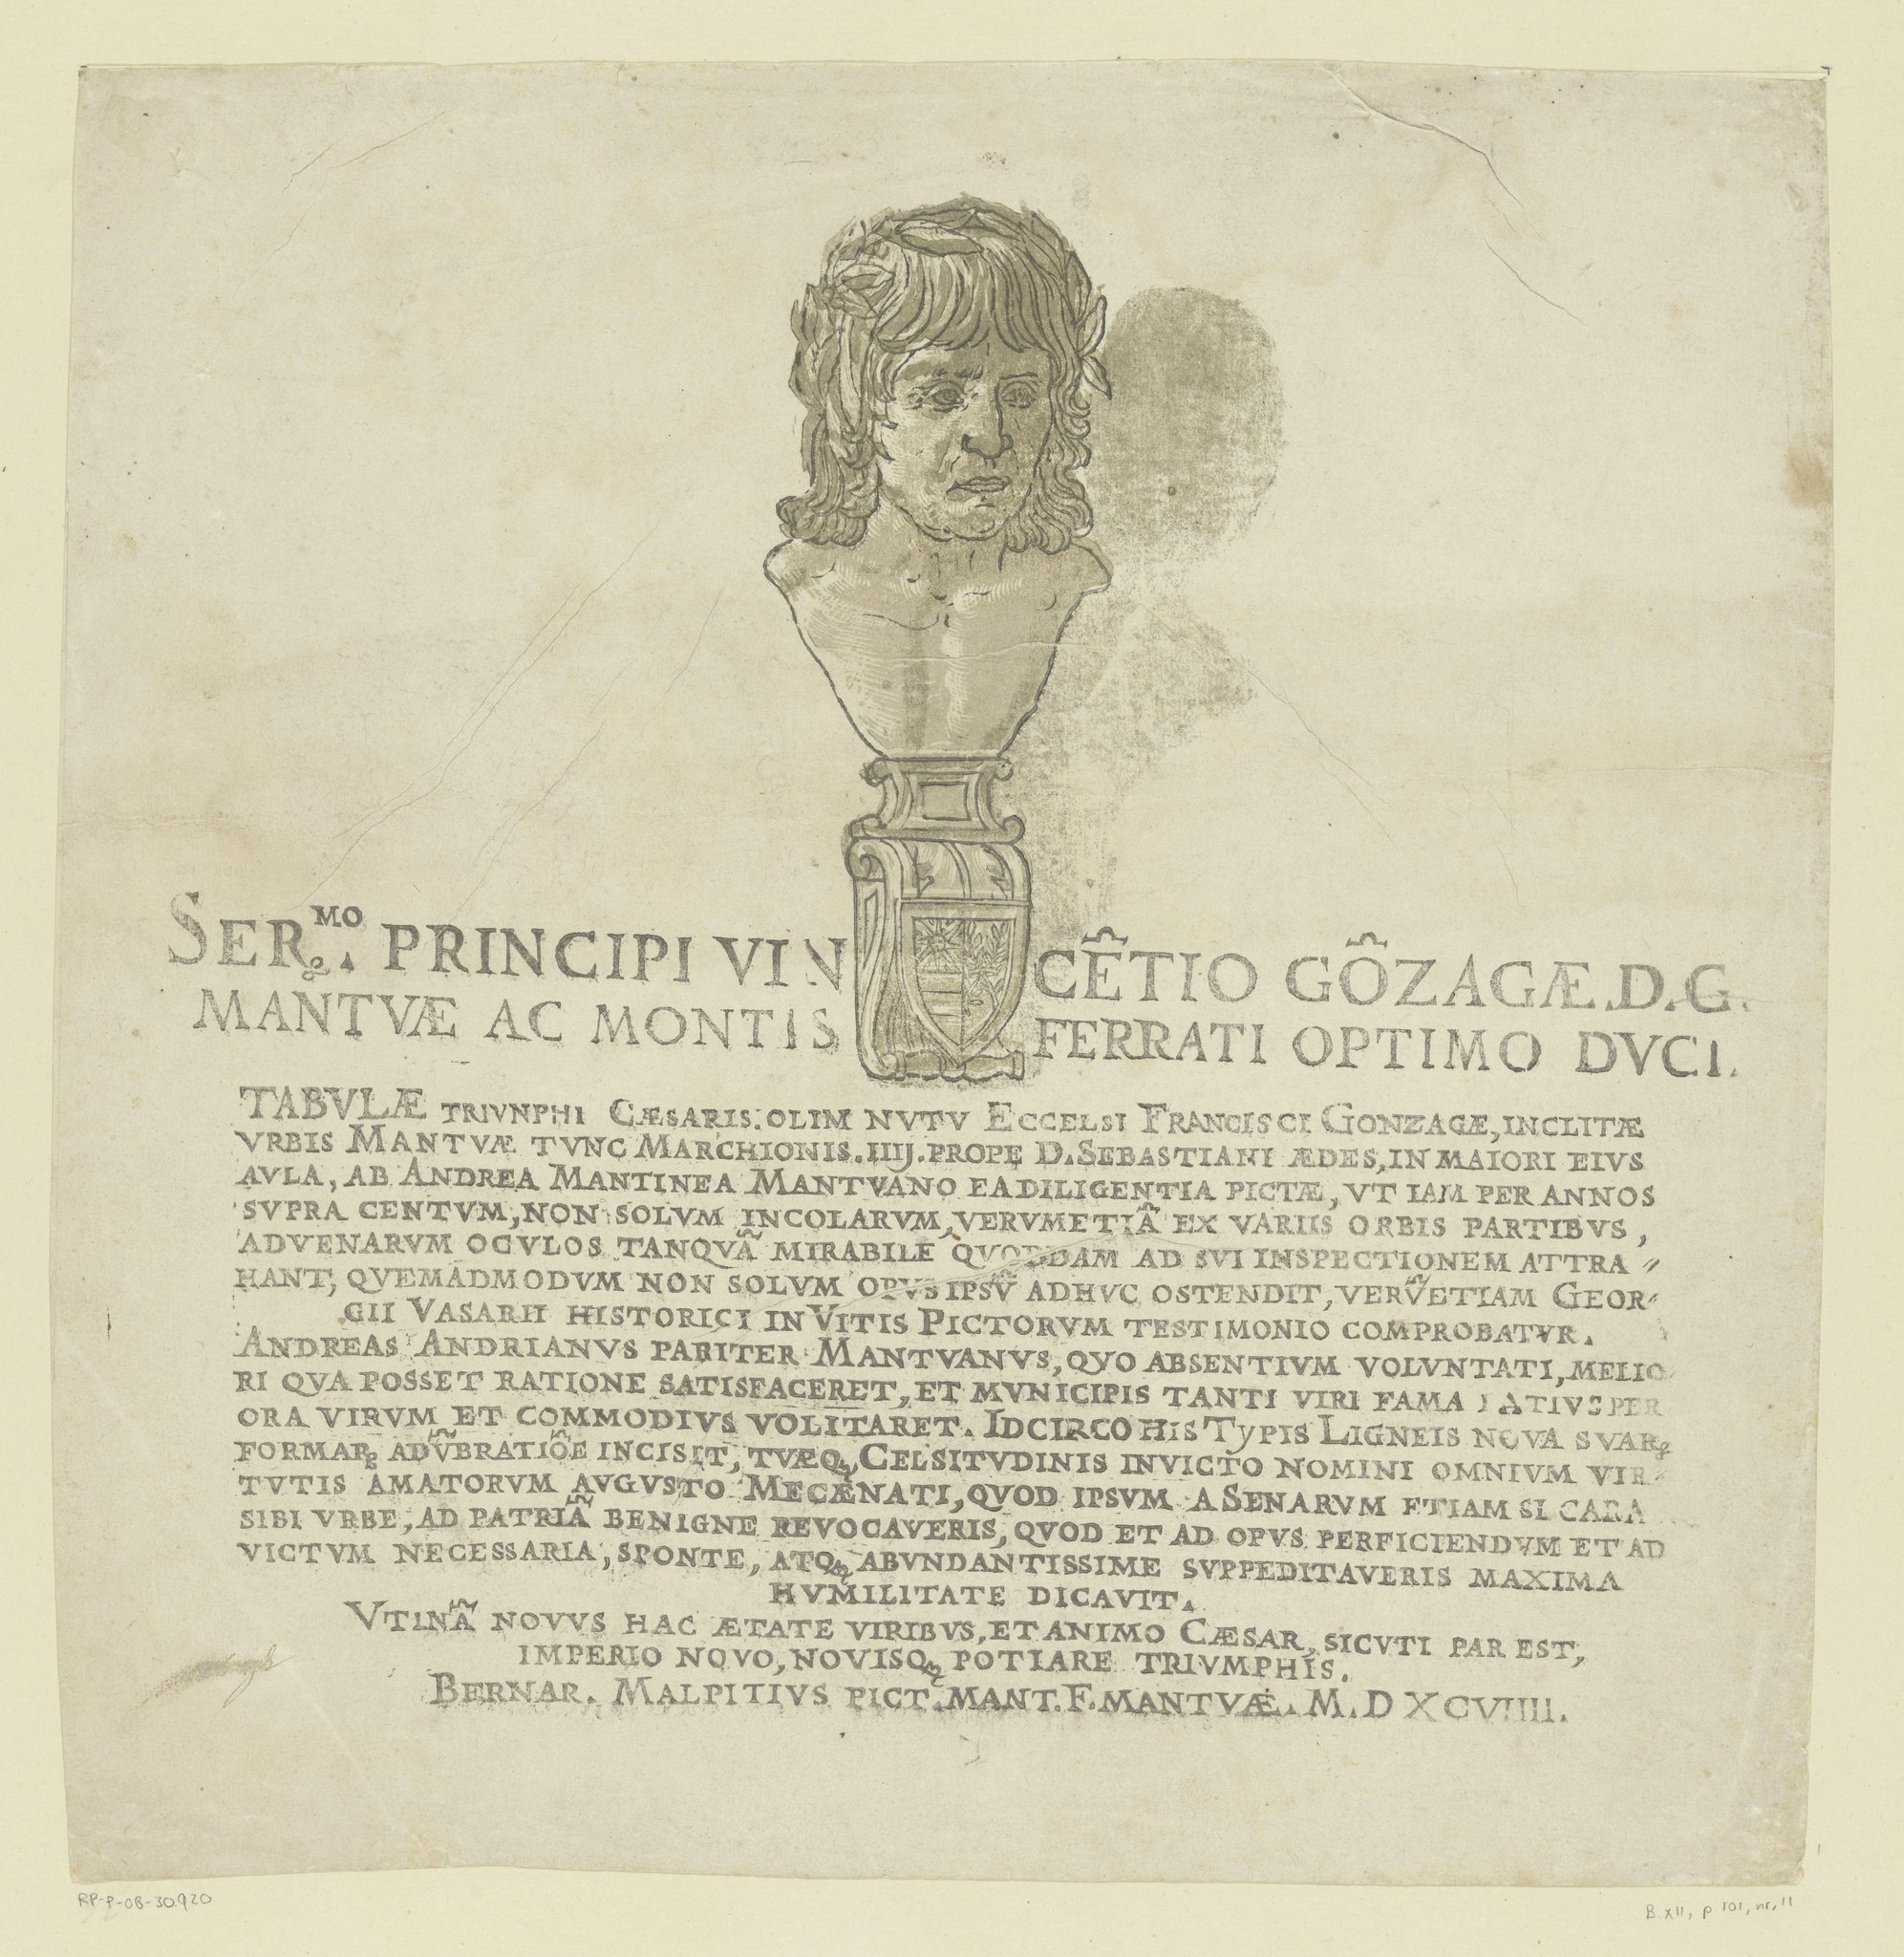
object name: titelprent, frontispice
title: Titelprent met portret van kunstenaar Andrea Mantegna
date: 1599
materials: paper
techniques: woodcut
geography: mantua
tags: andrea mantegna, historical persons, triumph of caesar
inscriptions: collector's mark: Lugt 240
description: Titelprent van een fries dat behalve de titelprent bestaat uit negen prenten die samen een triomftocht van Julius Caesar vormen. Bij de serie hoort tevens een prent met daarop zes Korinthische pilasters, bedoeld om te worden uitgeknipt en gebruikt als verbindingsstukken tussen de verschillende bladen.